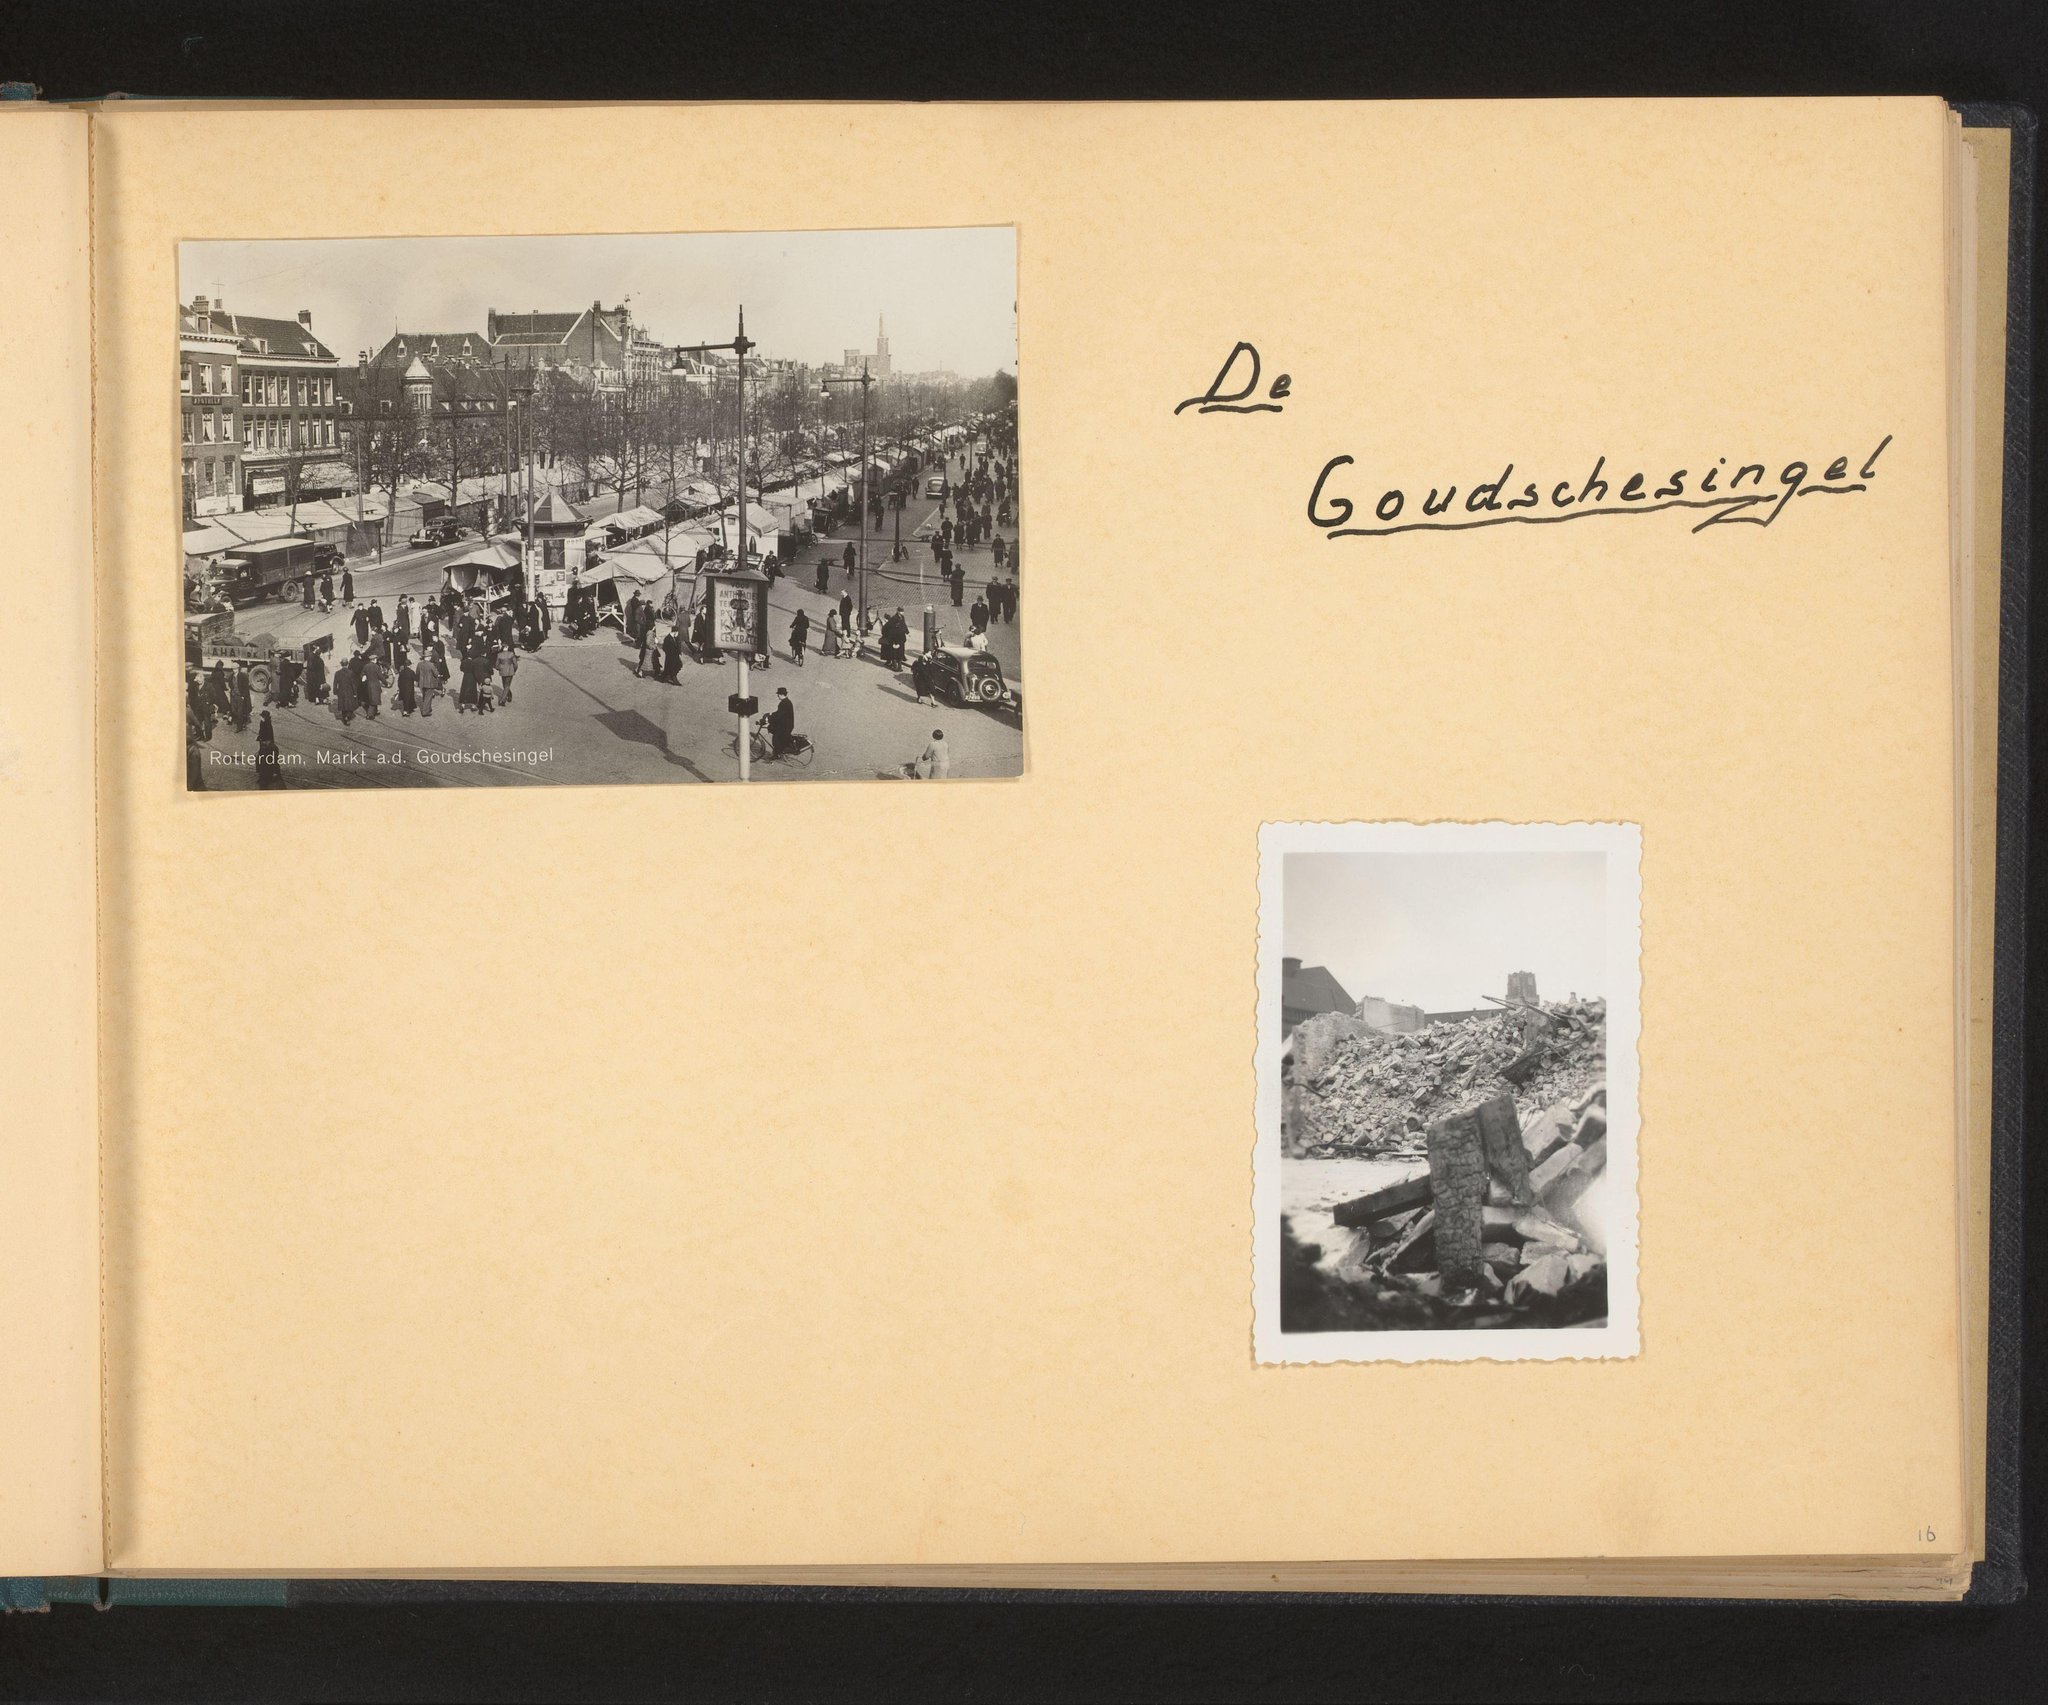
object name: photograph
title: De Goudschesingel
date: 1940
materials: cardboard, photographic support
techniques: gelatin silver print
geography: rotterdam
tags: non-combatants ~ war, devastated, ruined place or city (~ warfare), rotterdam, rotterdam blitz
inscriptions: inscription: ‘De Goudschesingel’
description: Albumblad met een prentbriefkaart en een foto van de markt aan de Goudsesingel, voor en na het bombardement van Rotterdam. Onderdeel van het fotoalbum over de verwoestingen van Nederlandse steden en infrastructuur in het begin van de Tweede Wereldoorlog.